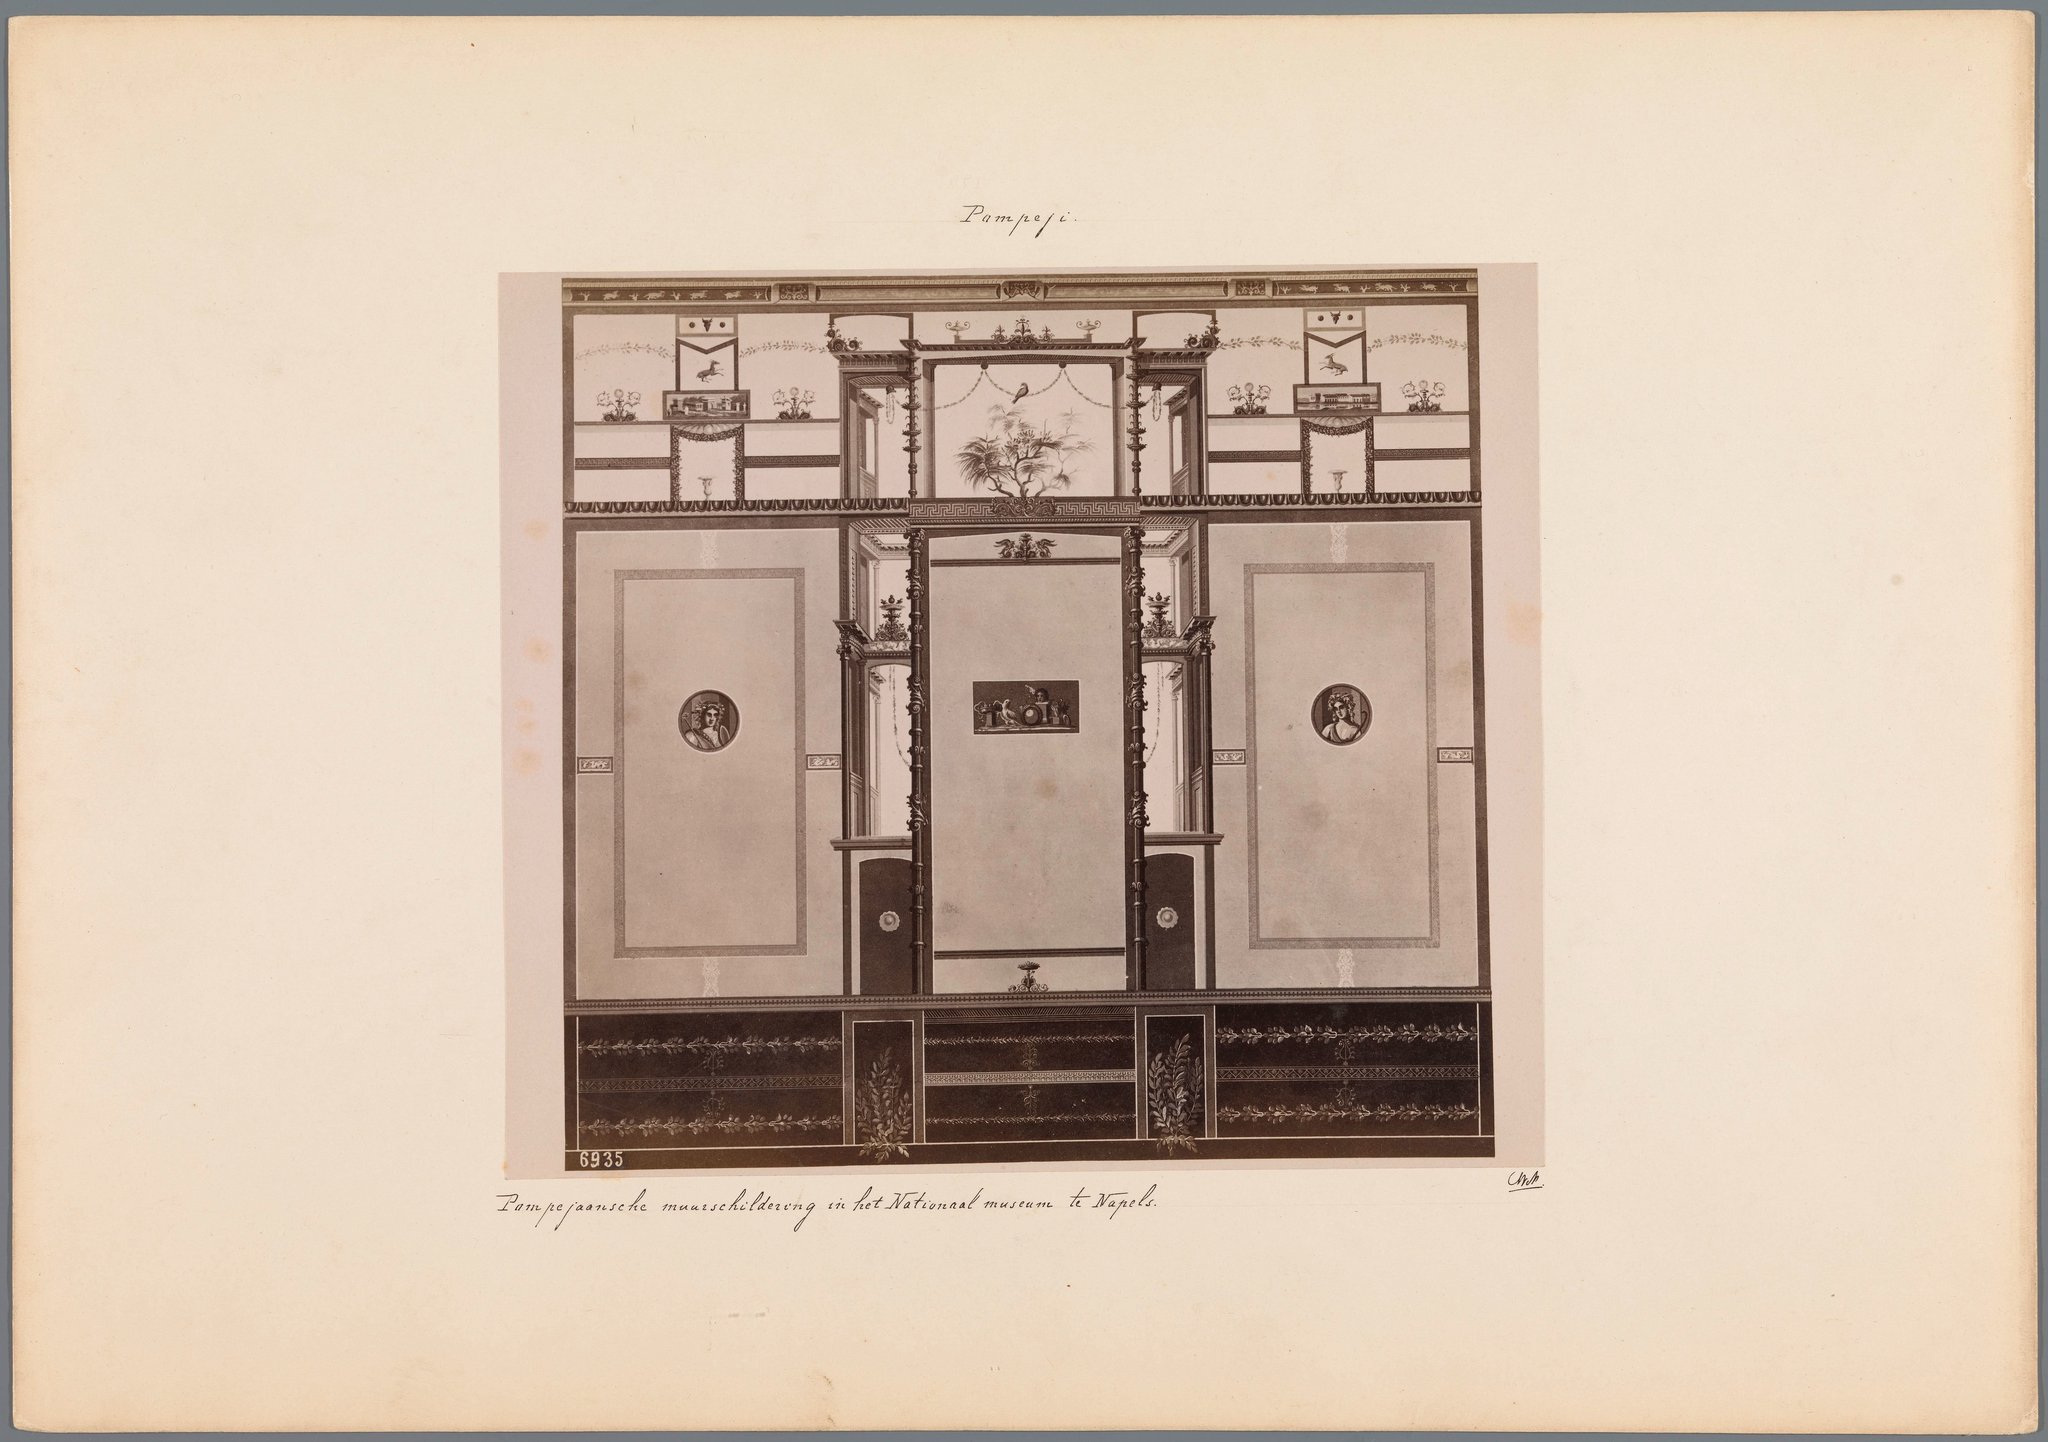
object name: photograph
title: Pompejaansche muurschildering uit het Nationaal museum te Napels.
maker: Anonymous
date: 1875-1900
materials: cardboard, photographic support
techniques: albumen print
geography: pompeii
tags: drawing, sketch, painting (including book-illumination, miniature-painting) (+ plaster ~ arts), portrait, self-portrait of architect, ornament derived from architectural details, still life of miscellaneous objects, pompeii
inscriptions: number: ‘6935’, collector's mark: ‘INSTITUUT VOOR KUNST-NIJVERHEIDSONDERWIJS GABRIËL METSUSTRAAT No. 16 AMSTERDAM’, collector's mark: ‘KUNSTNIJVERHEIDSCHOOL QUELLINUS AMSTERDAM FRANS HALSSTRAAT 14.’, inscription: ‘CWN.’, inscription: ‘Pompeji.’